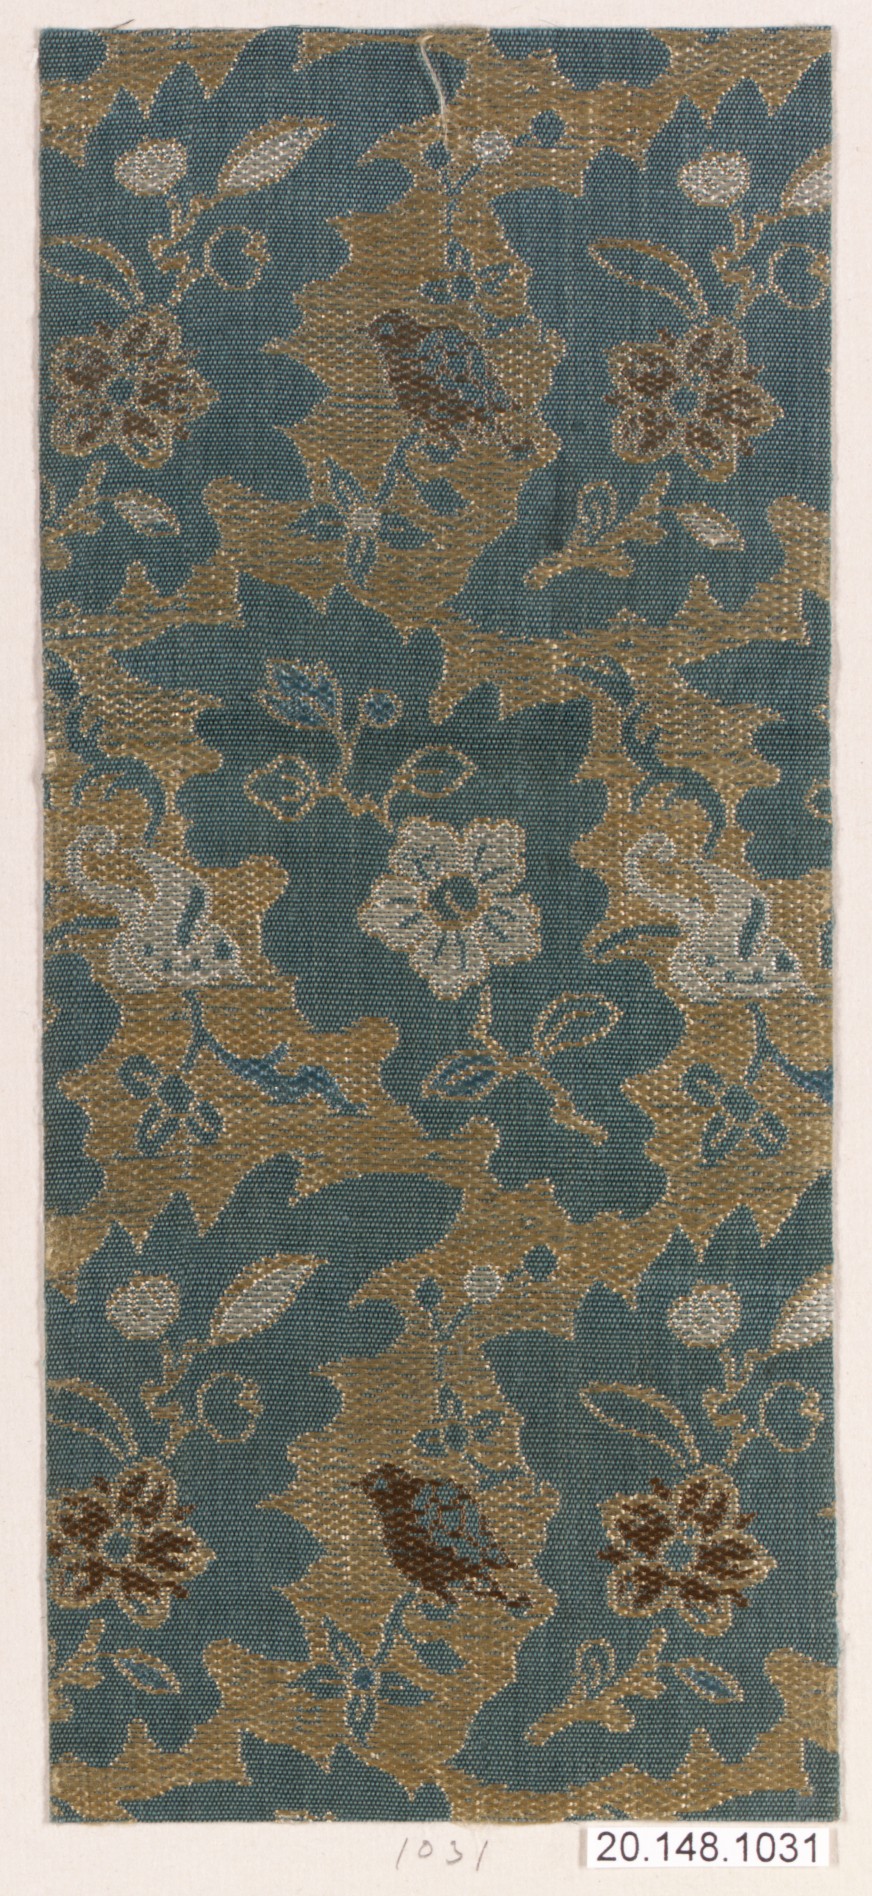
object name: piece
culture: japanese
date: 1701-1800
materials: silk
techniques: compound weave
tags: flowers